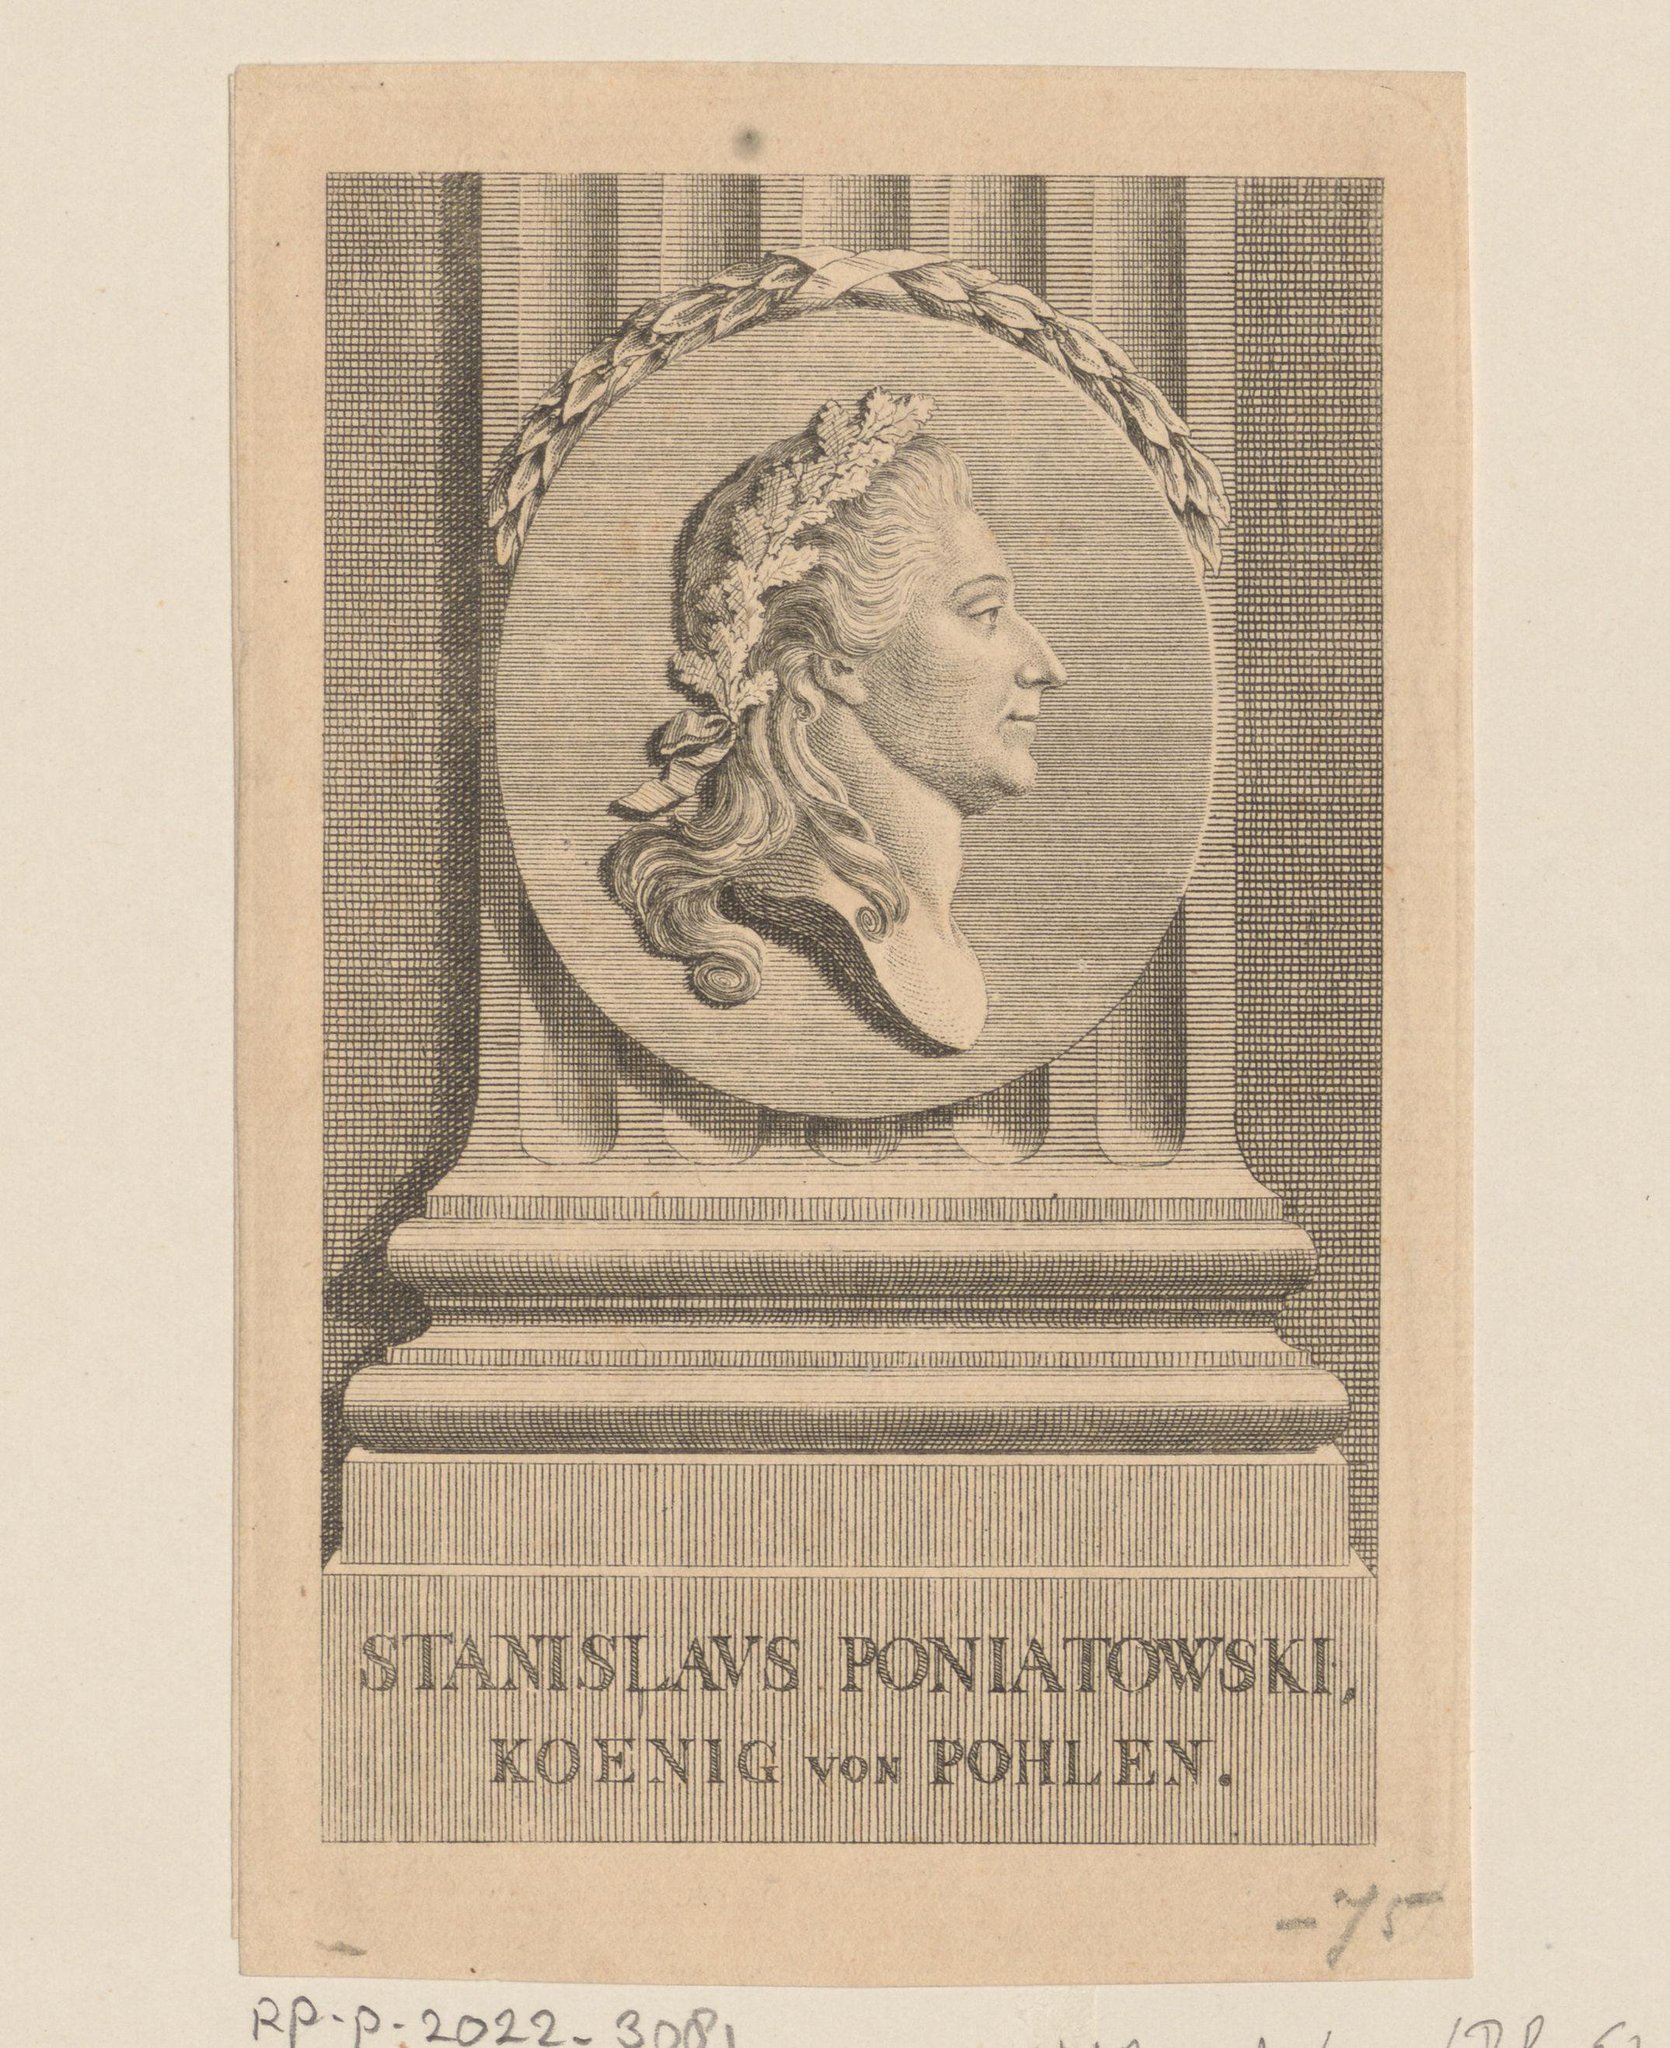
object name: print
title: Portret van Stanisław August Poniatowski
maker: Anonymous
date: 1710-1782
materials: paper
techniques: etching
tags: stanisław august poniatowski (koning van polen), historical persons, king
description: Prent waarschijnlijk uit: Historisches portefeuille 10 (1782), oktober 1782.